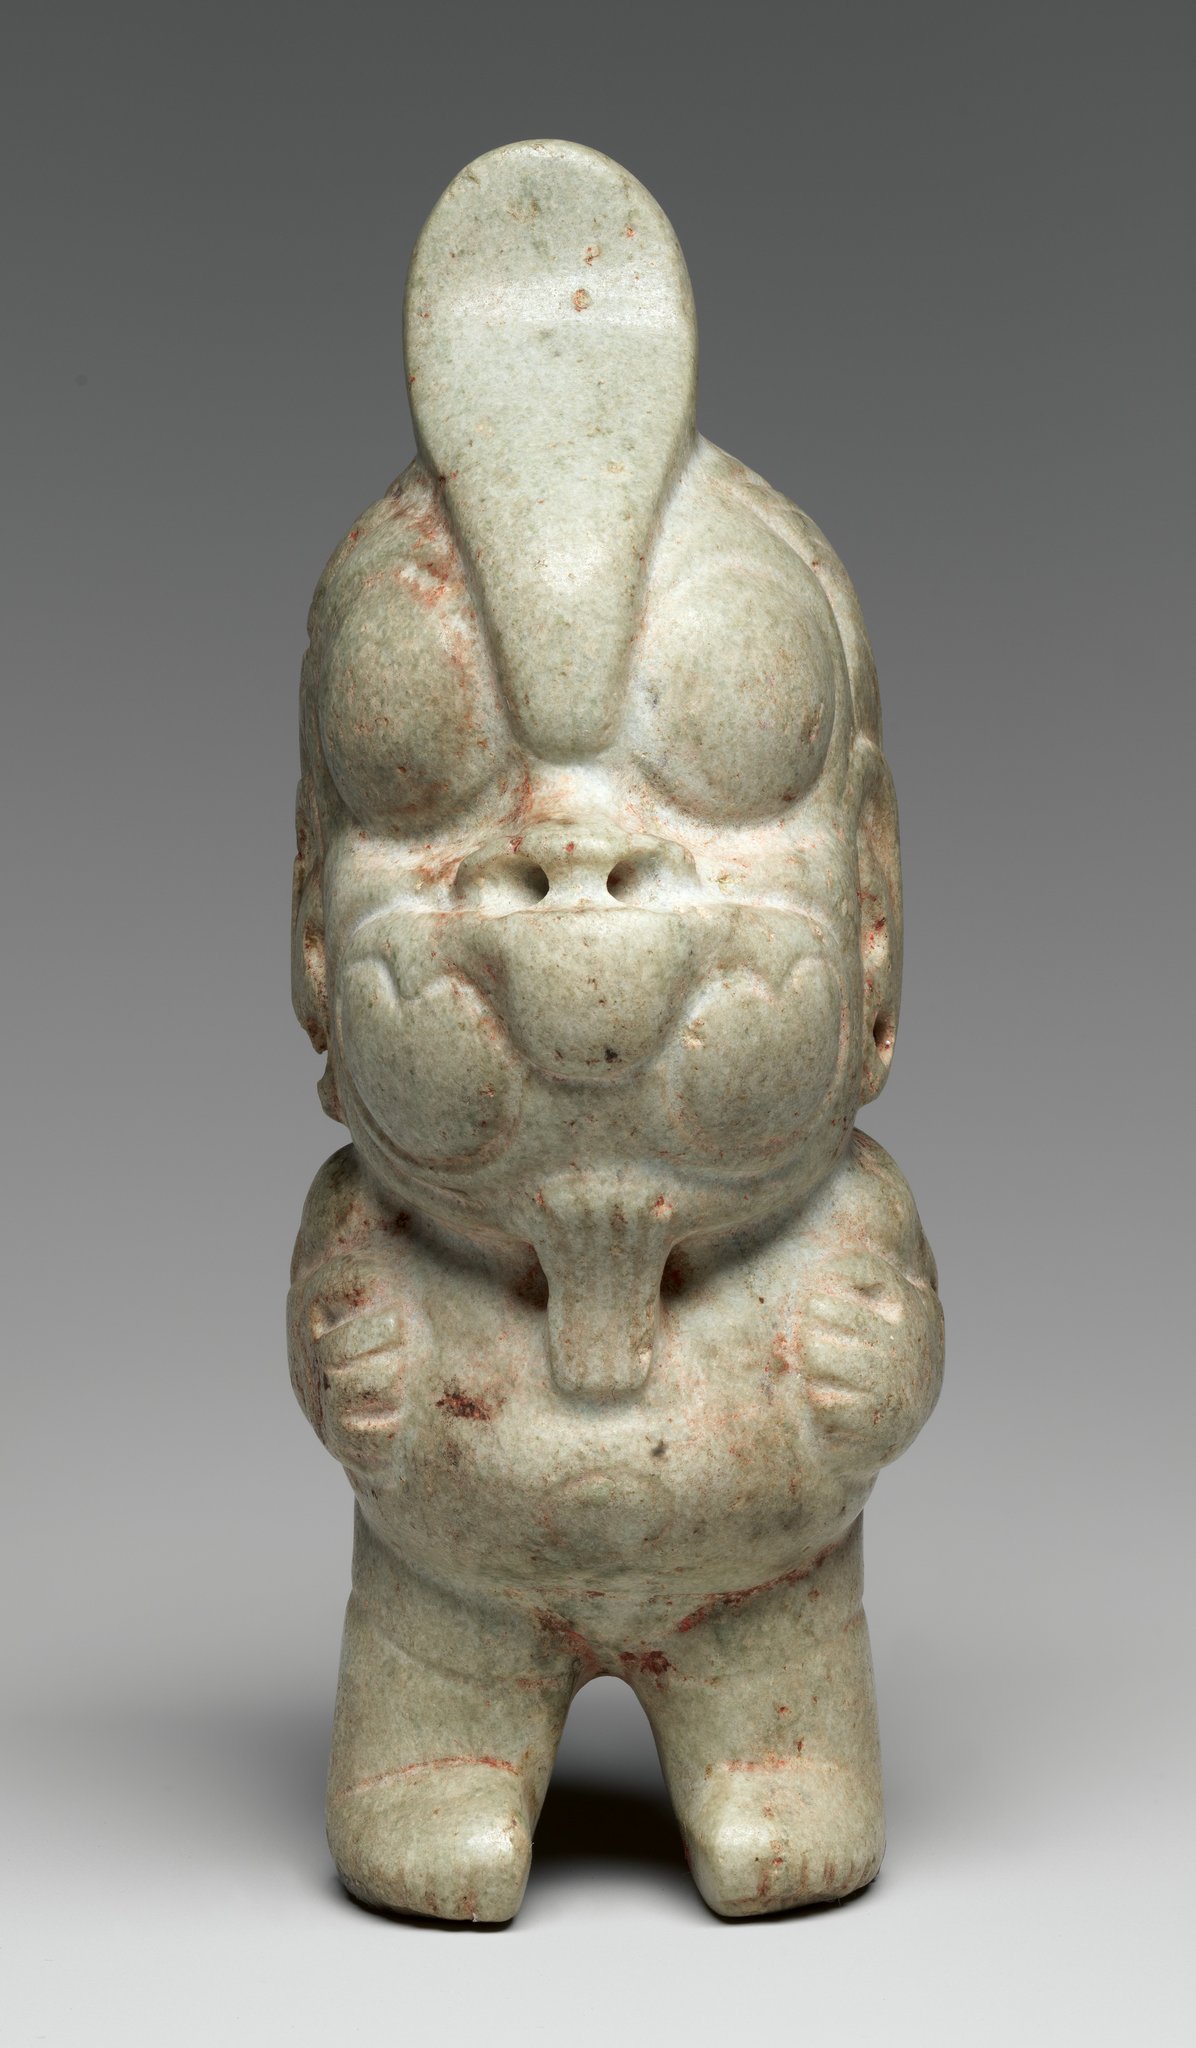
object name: figure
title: Eagle transformation figure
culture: olmec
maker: olmec artist(s)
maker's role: artist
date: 1000-400 BCE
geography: mexico